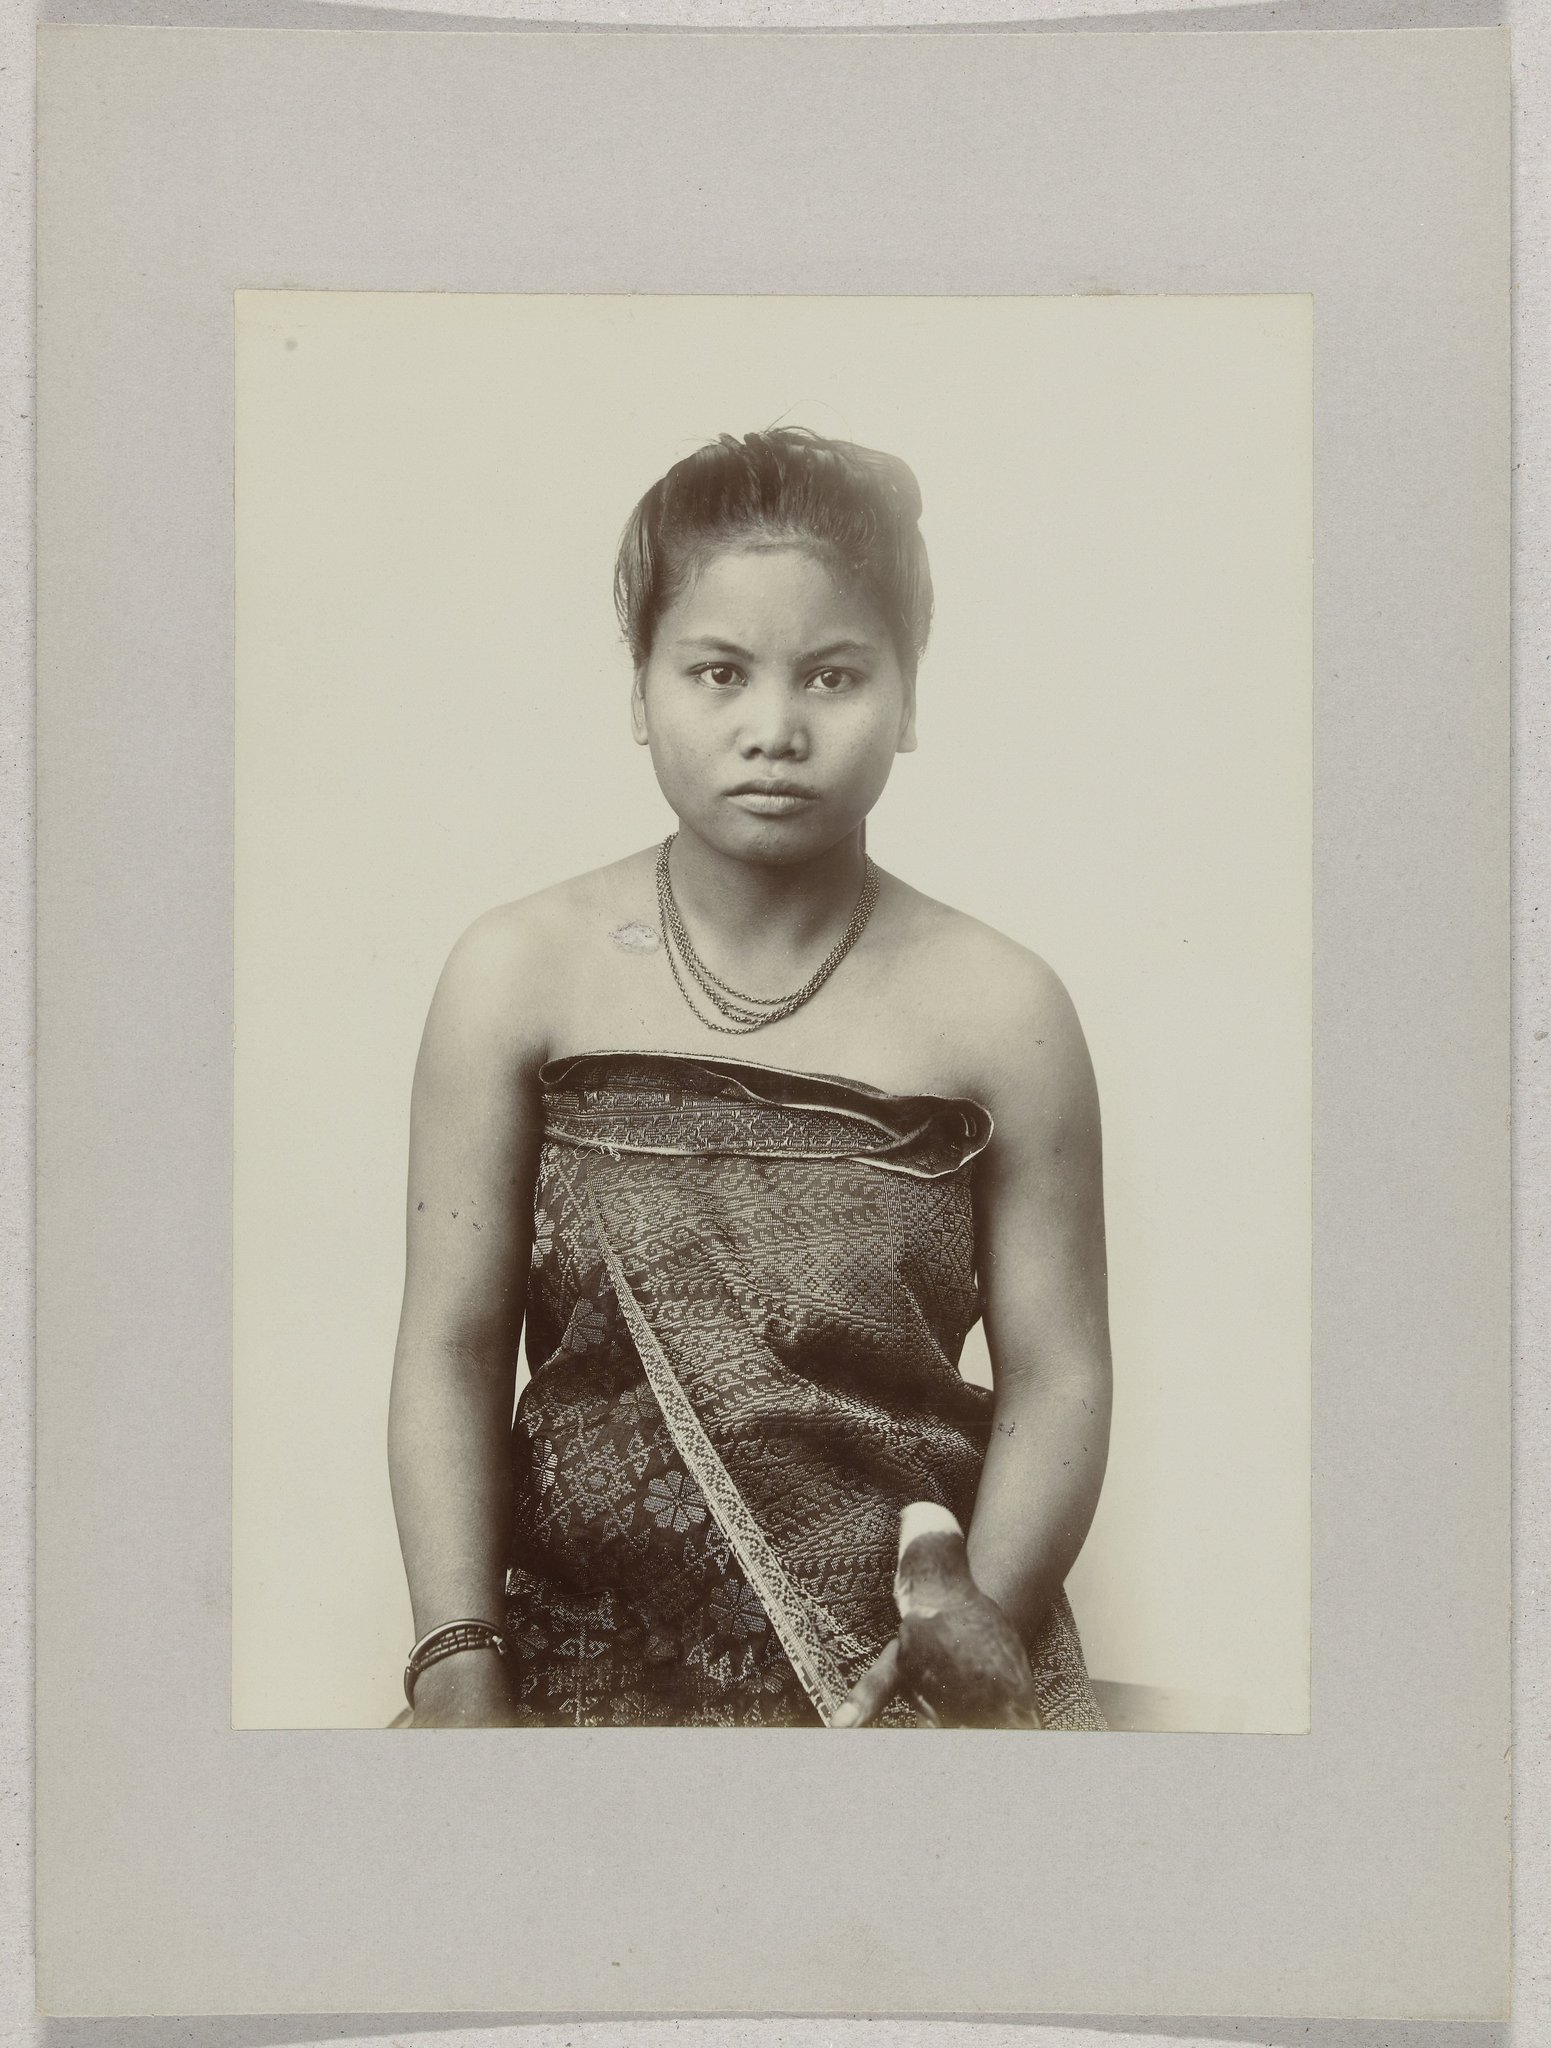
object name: photograph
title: Studioportret van een vrouw met een vogel in Nederlands-Indië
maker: Anonymous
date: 1895-1915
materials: cardboard, paper, photographic support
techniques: gelatin silver print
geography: dutch east indies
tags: indonesia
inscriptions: number: ‘34’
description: Portret van een vrouw met een vogel, gemaakt in een studio, Nederlands-Indië